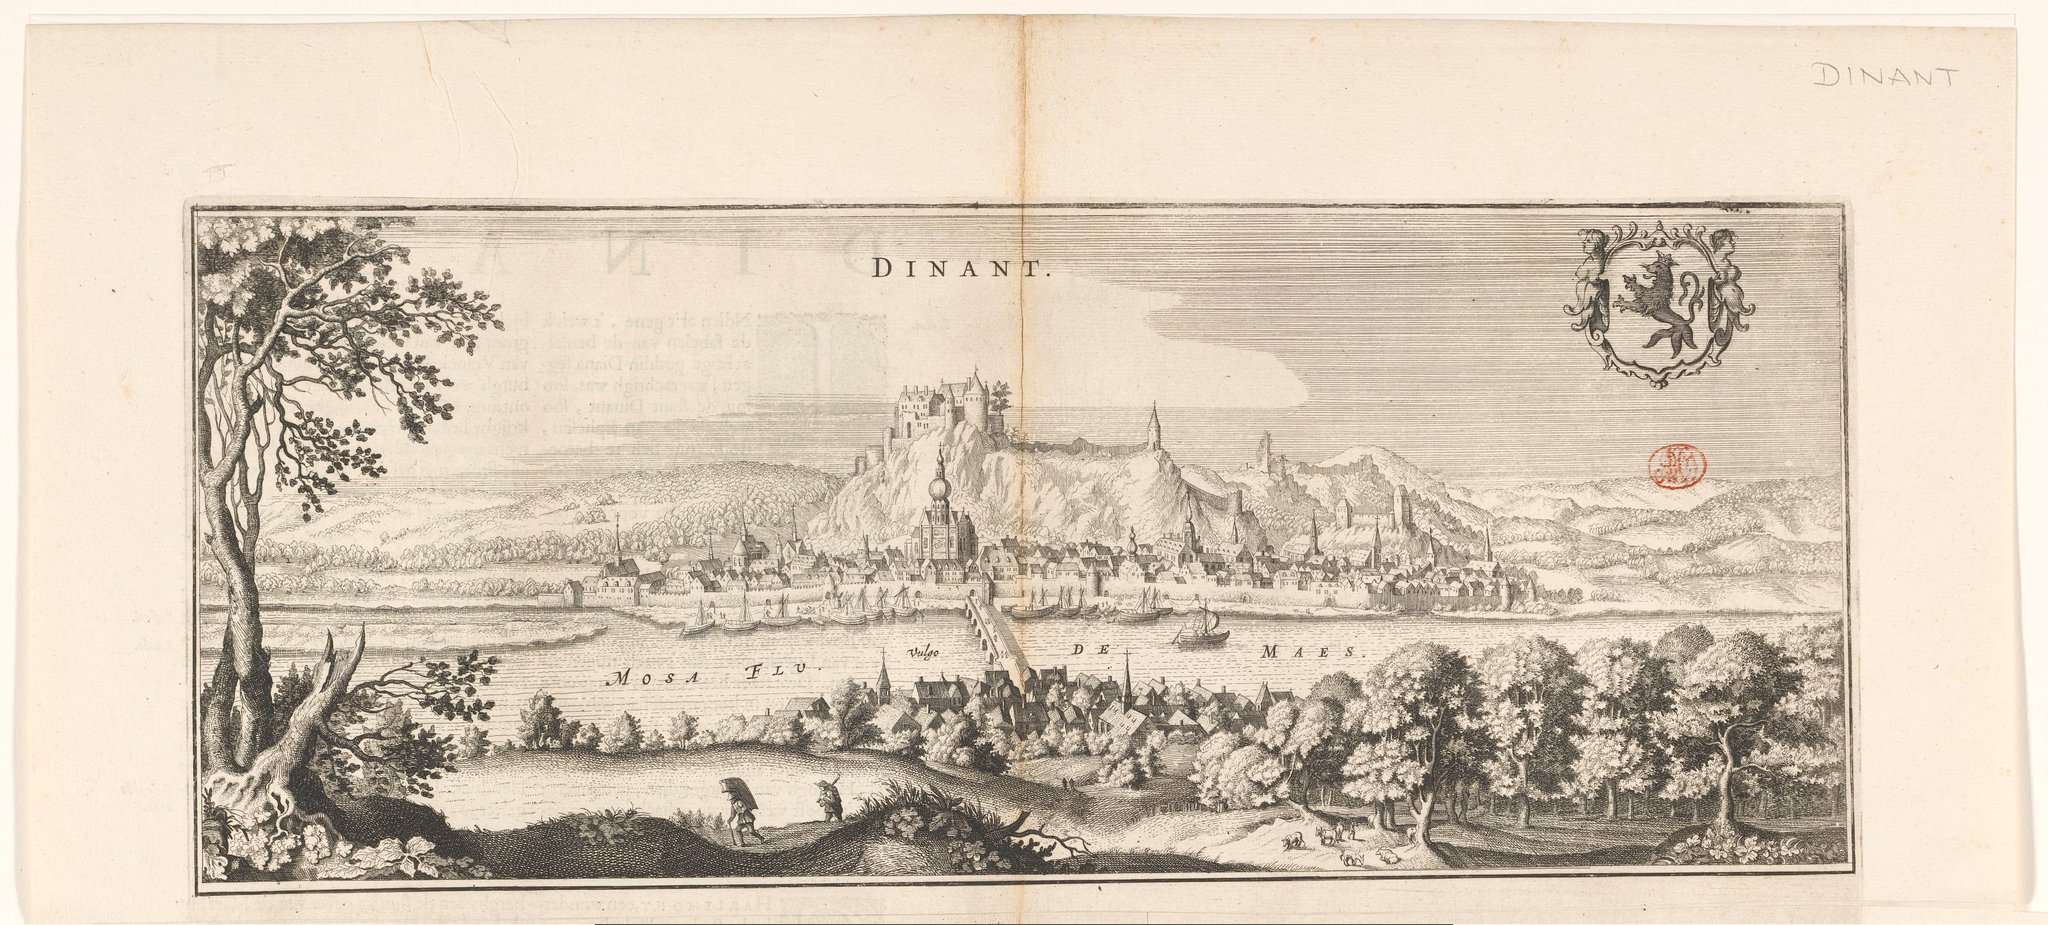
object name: print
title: Dinant / Walcourt / Charlemont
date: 1652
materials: paper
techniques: engraving, etching, letterpress printing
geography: amsterdam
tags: maps of cities, coat of arms (as symbol of the state, etc.) (+ province; provincial), prospect of city, town panorama, silhouette of city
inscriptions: collector's mark: Lugt 195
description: Boven een gezicht op Dinant, met rechtsboven een cartouche met het wapen van Dinant. Rechtsonder een plattegrond van Walcourt in vogelvluchtperspectief. De titelcartouche rechtsonder. Linksonder een plattegrond van het fort Charlemont in vogelvluchtperspectief. De titelcartouche rechtsonder. Met Nederlandse tekst op verso.